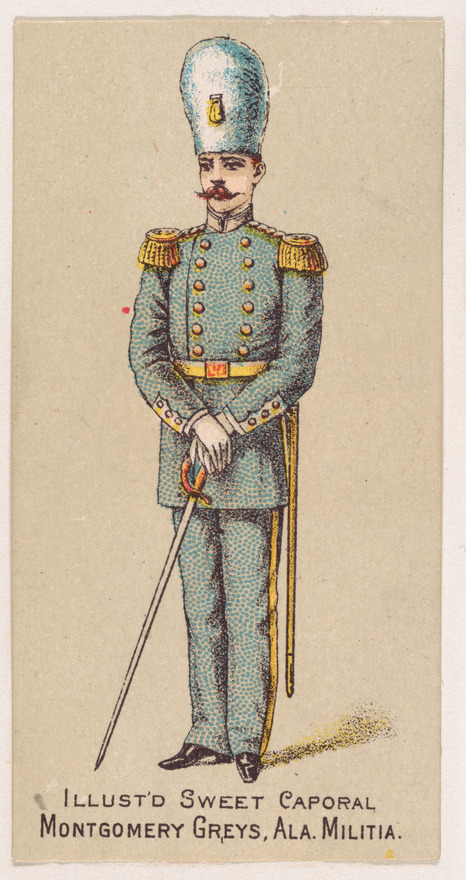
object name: print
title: Montgomery Greys, Alabama Militia, from the Military Series (N224) issued by Kinney Tobacco Company to promote Sweet Caporal Cigarettes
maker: kinney brothers tobacco company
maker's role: publisher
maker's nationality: american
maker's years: 1869-2011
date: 1888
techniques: color lithograph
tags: military,swords,men